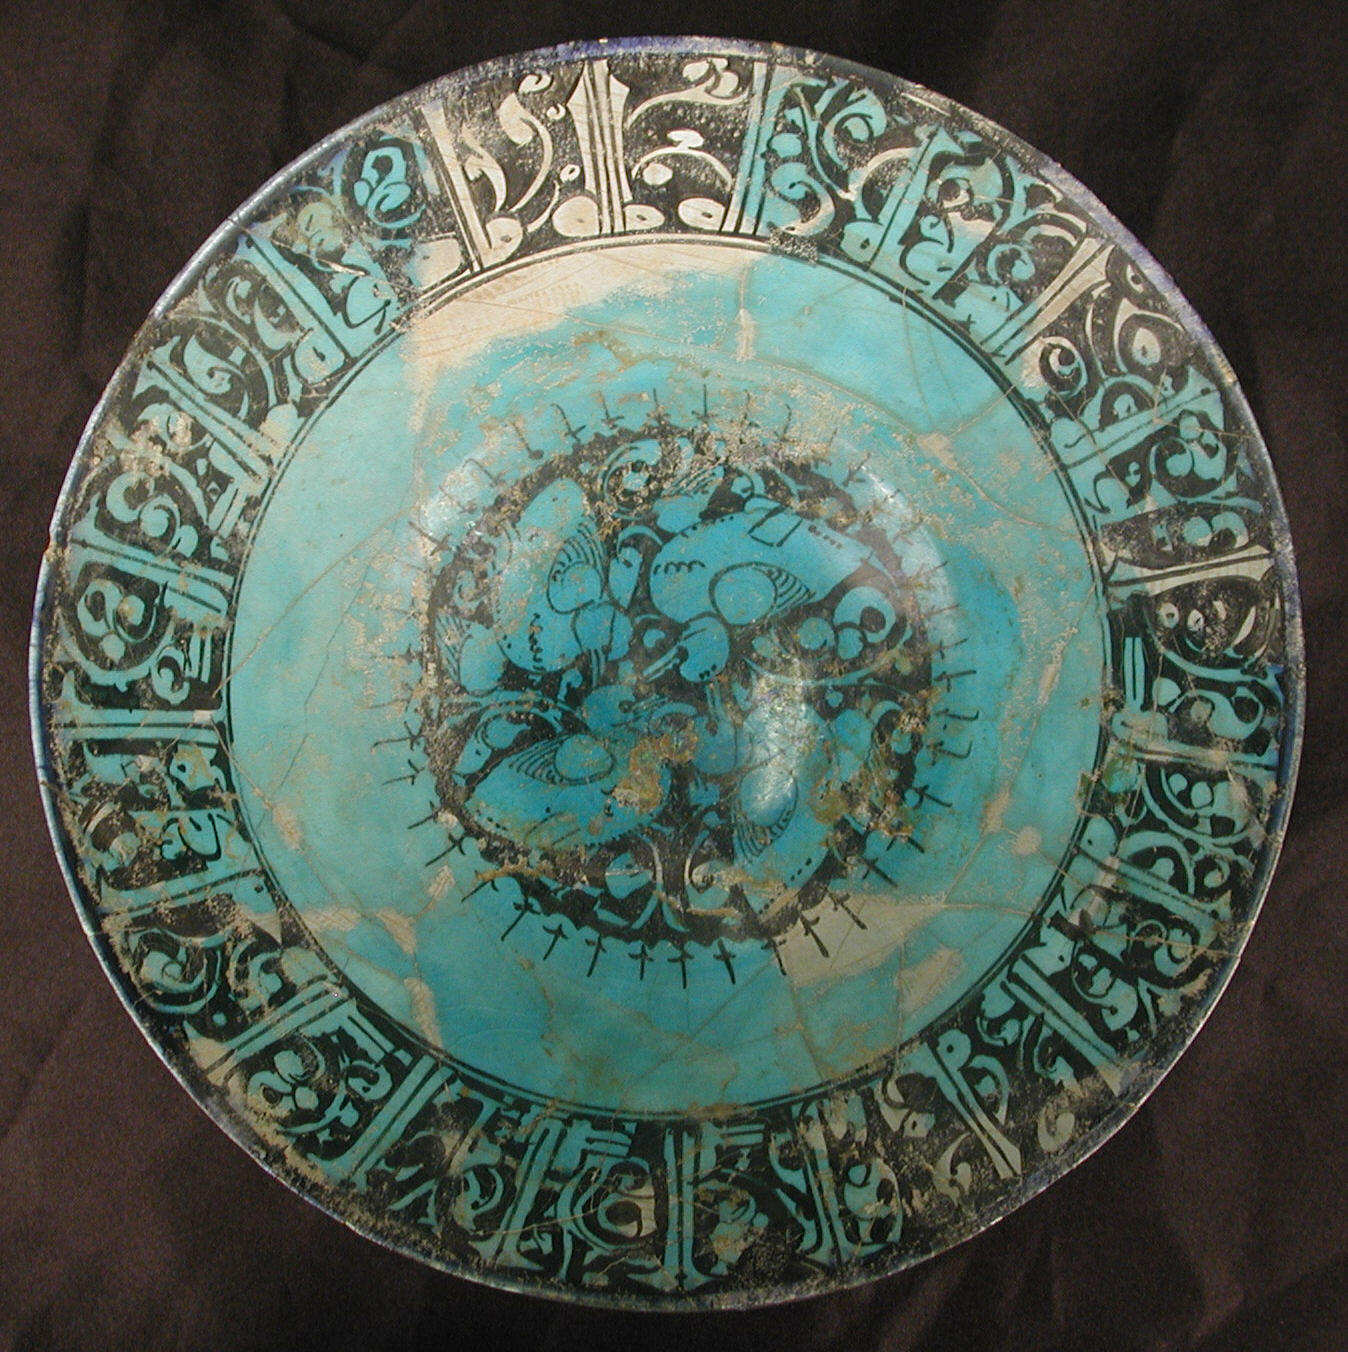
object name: bowl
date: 1201-1300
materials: stonepaste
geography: iran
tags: birds